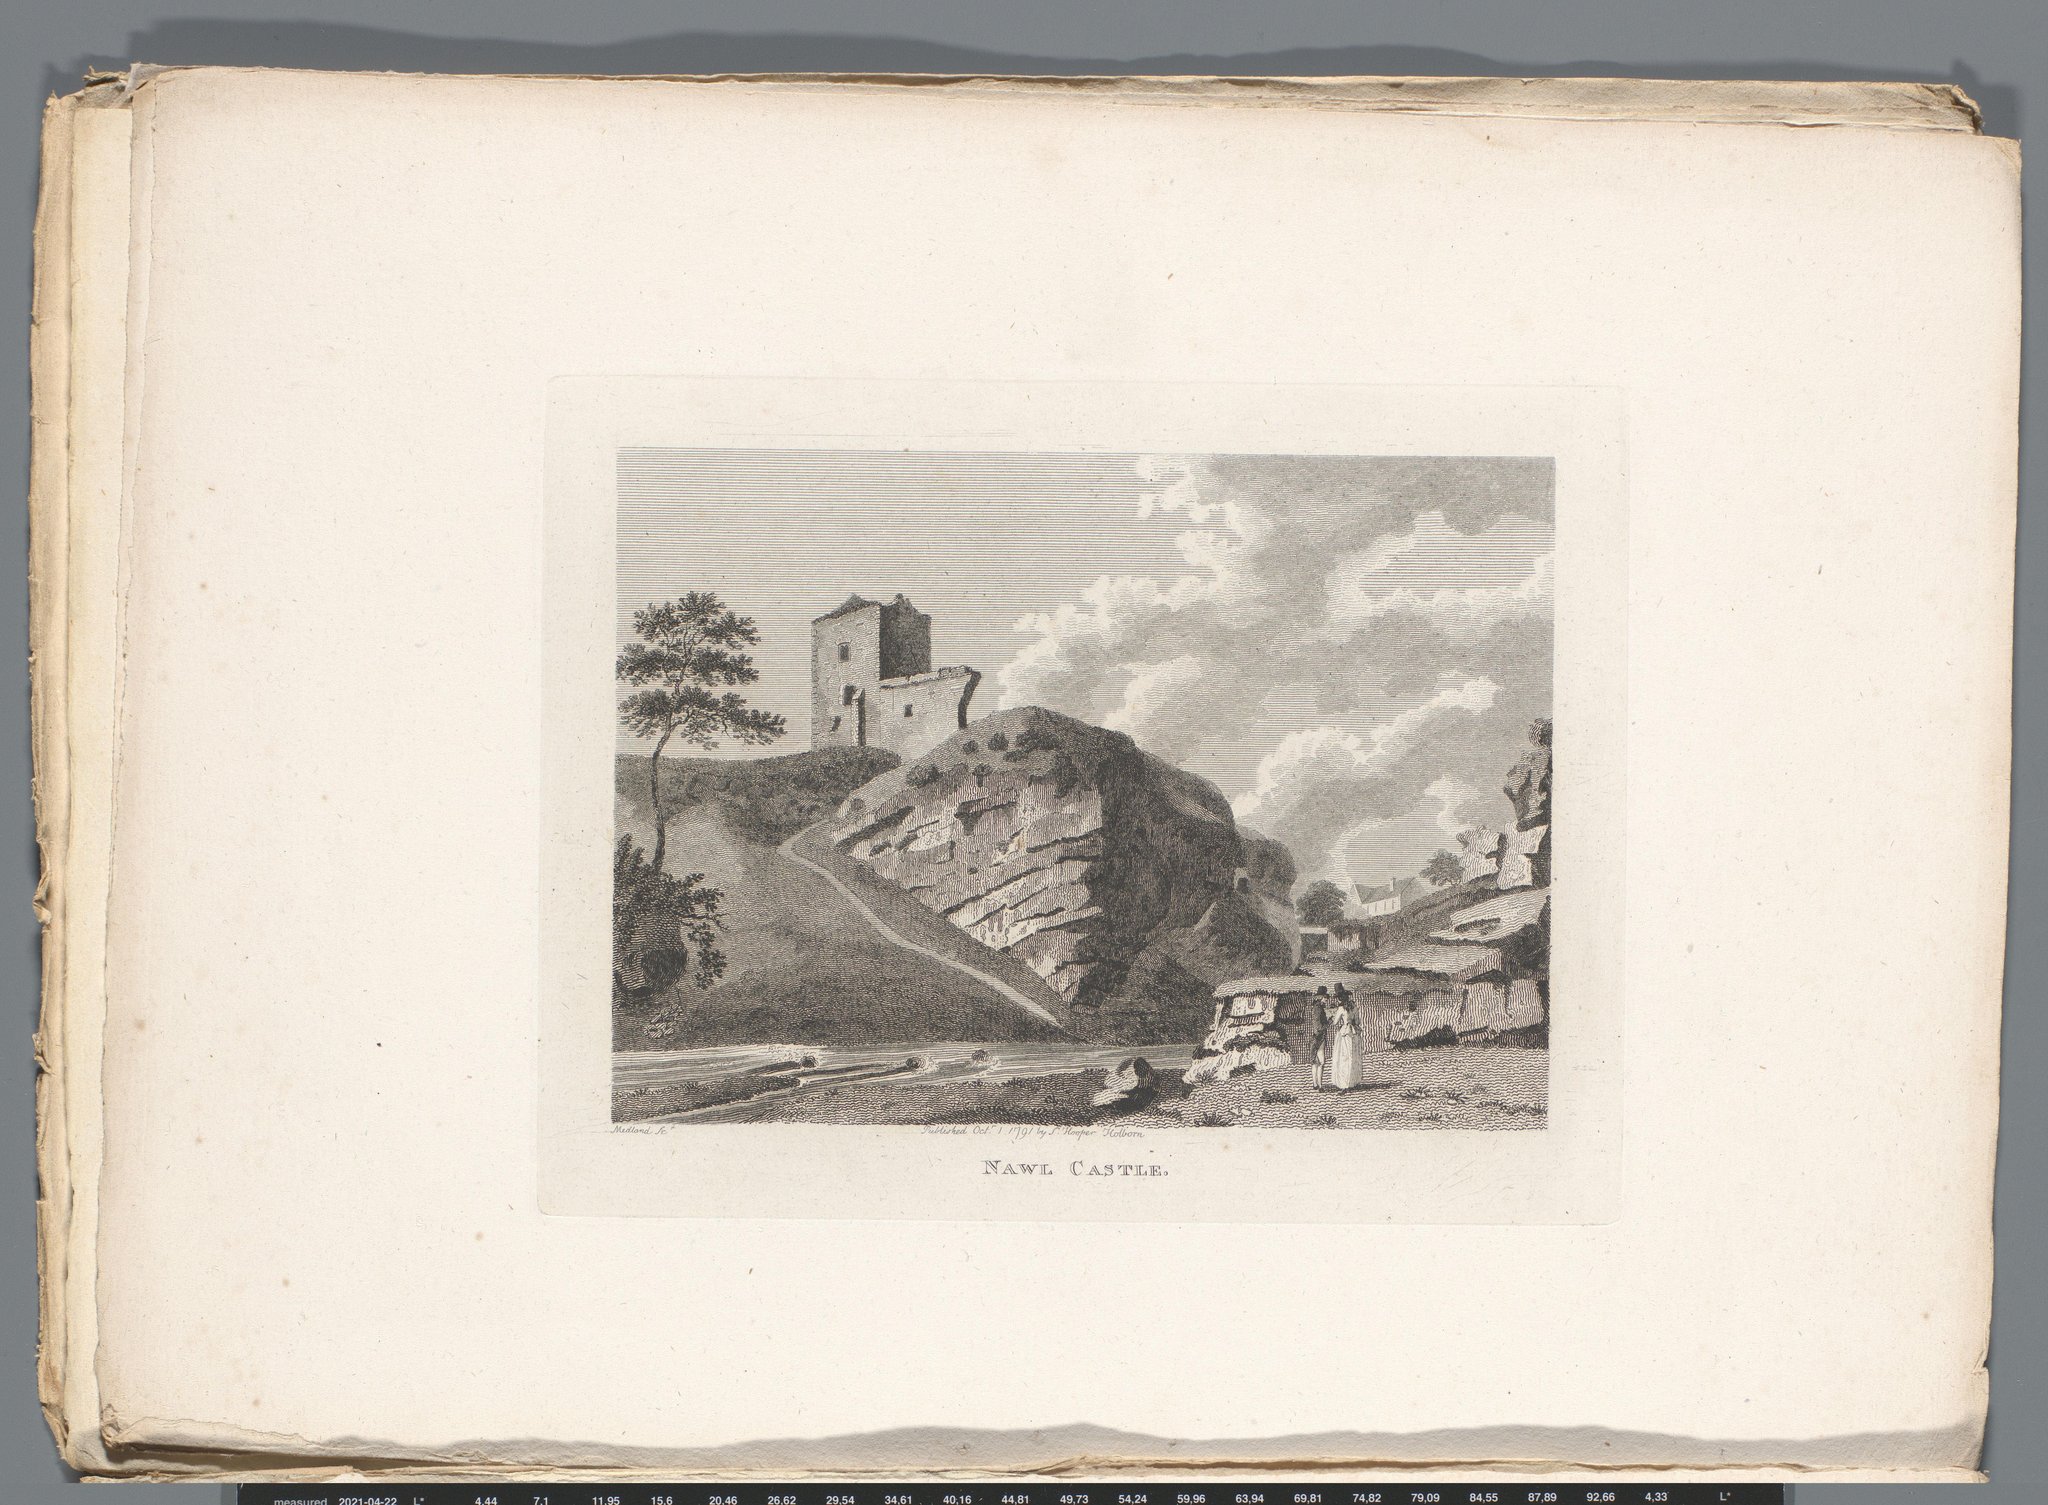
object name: book illustration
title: Gezicht op de ruïnes van Nawl Castle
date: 1791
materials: paper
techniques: etching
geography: london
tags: landscape with ruins, landscape with tower or castle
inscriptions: date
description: Prent verschenen in: Grose, Francis. The antiquities of Ireland. Londen: S. Hooper, 1795, dl. 2.